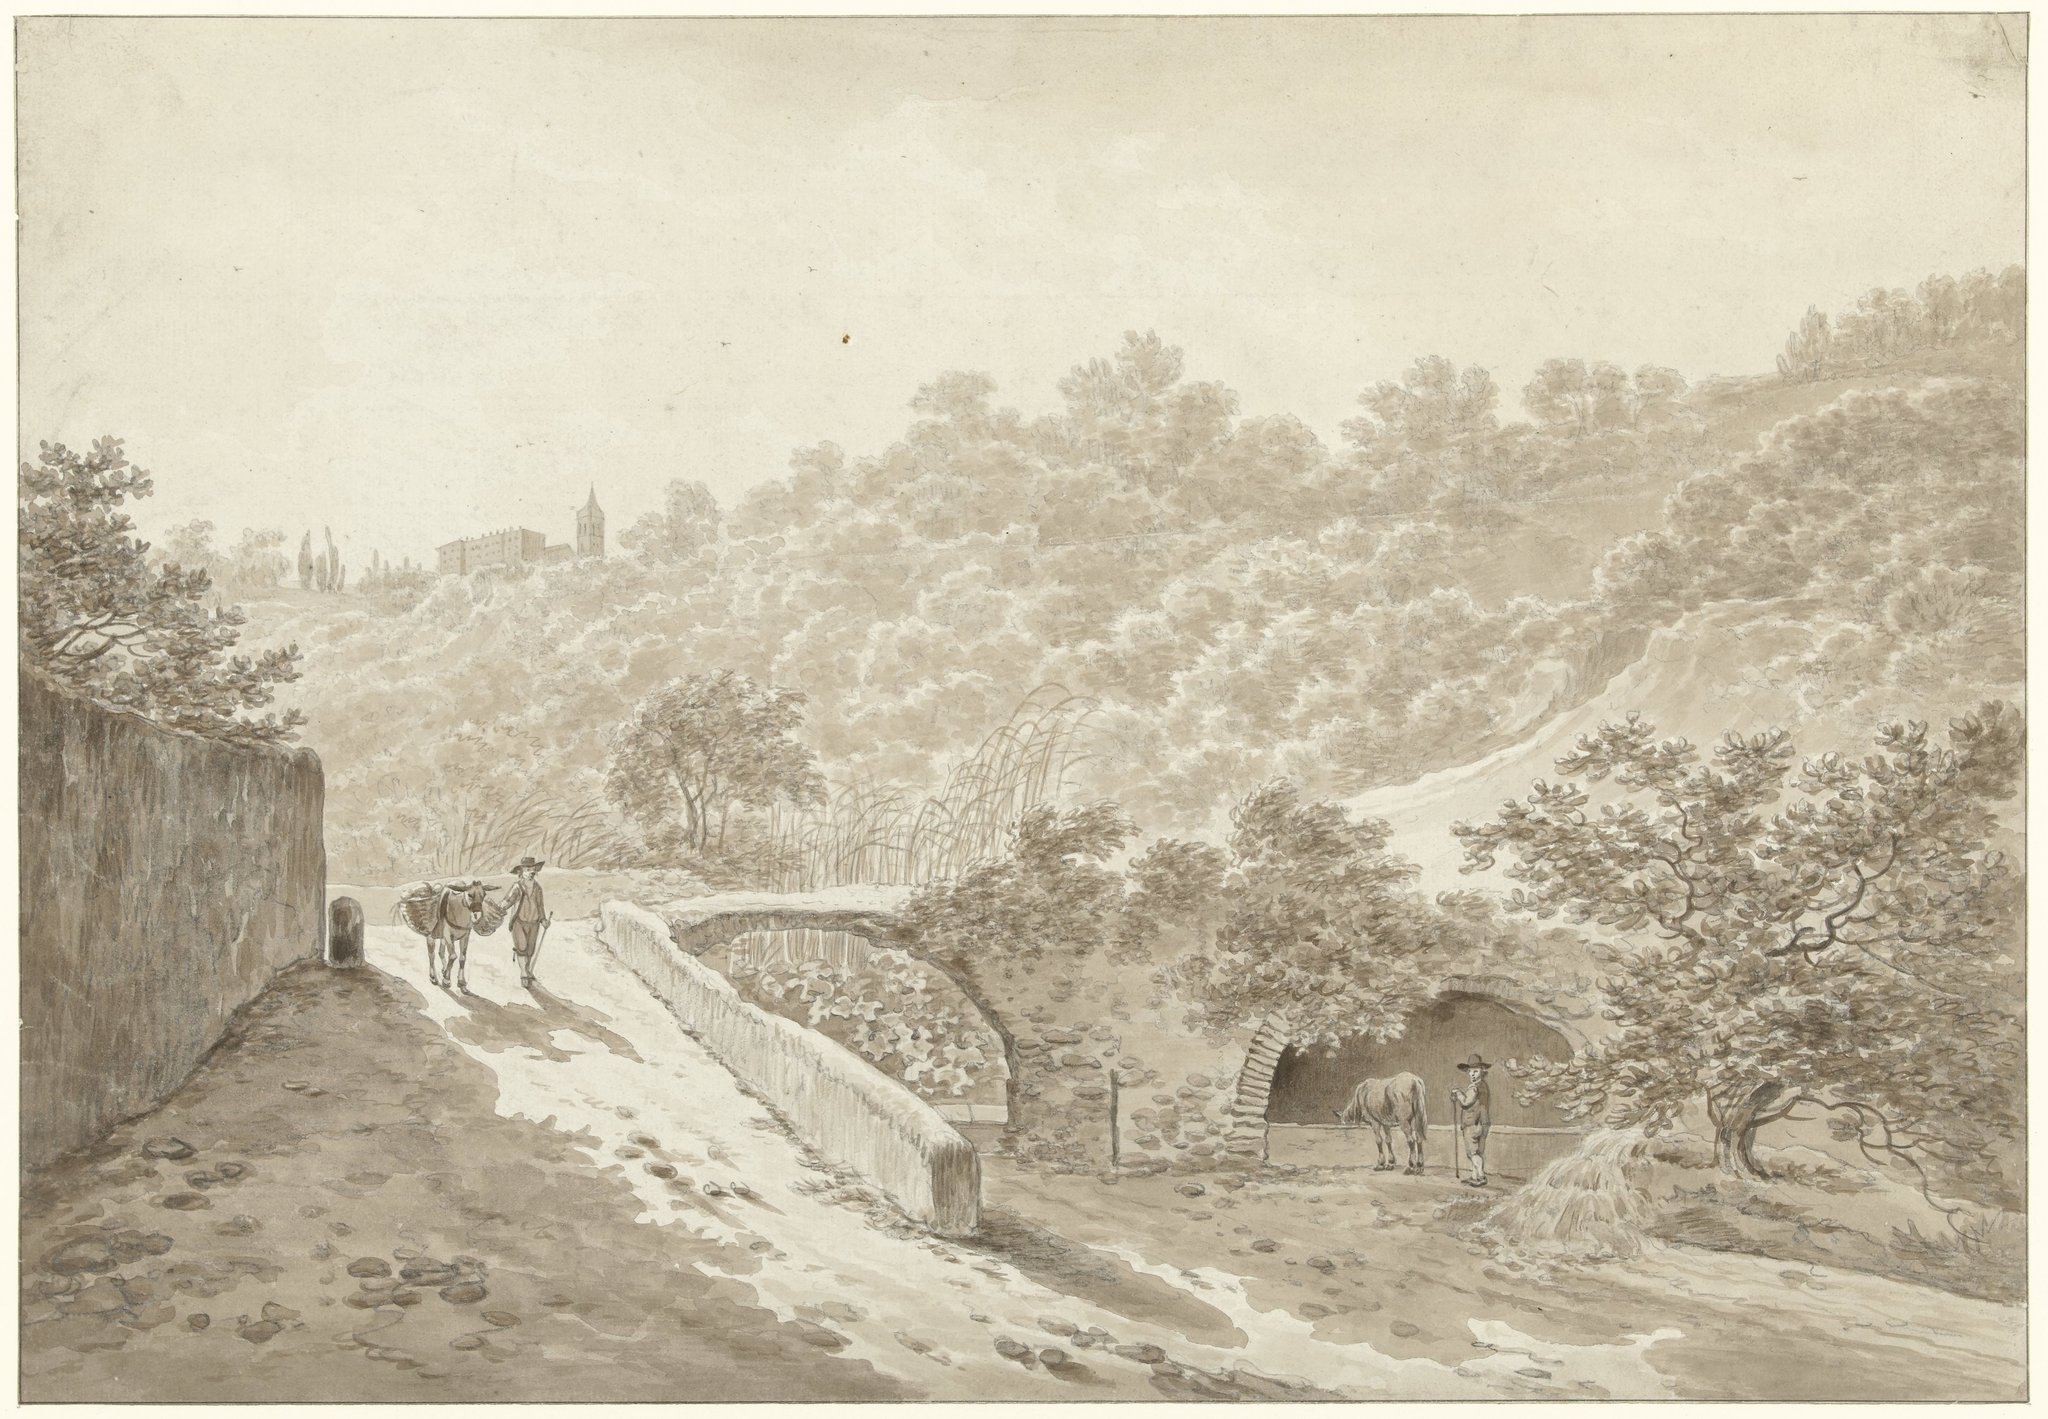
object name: drawing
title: De Villa d'Este te Tivoli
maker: daniël dupré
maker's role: draughtsman, print maker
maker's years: 1751-1817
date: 1761-1817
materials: paper, pencil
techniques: brush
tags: landscapes, tivoli